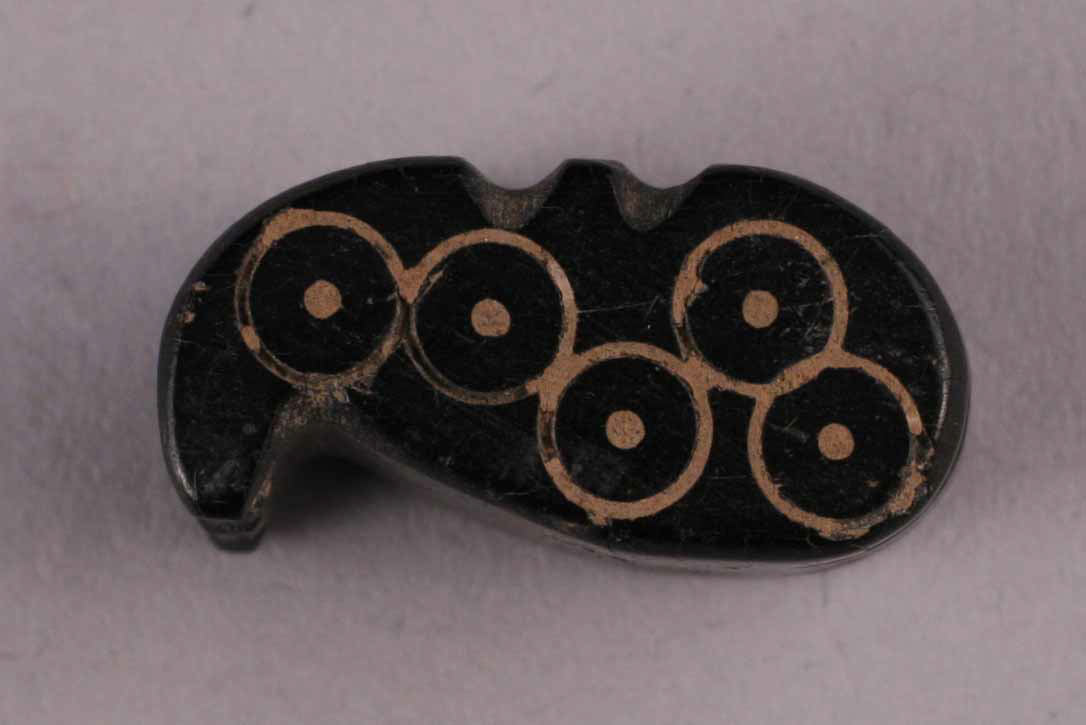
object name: jewellery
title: Jewelry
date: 701-1200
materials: bone, stone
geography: iran